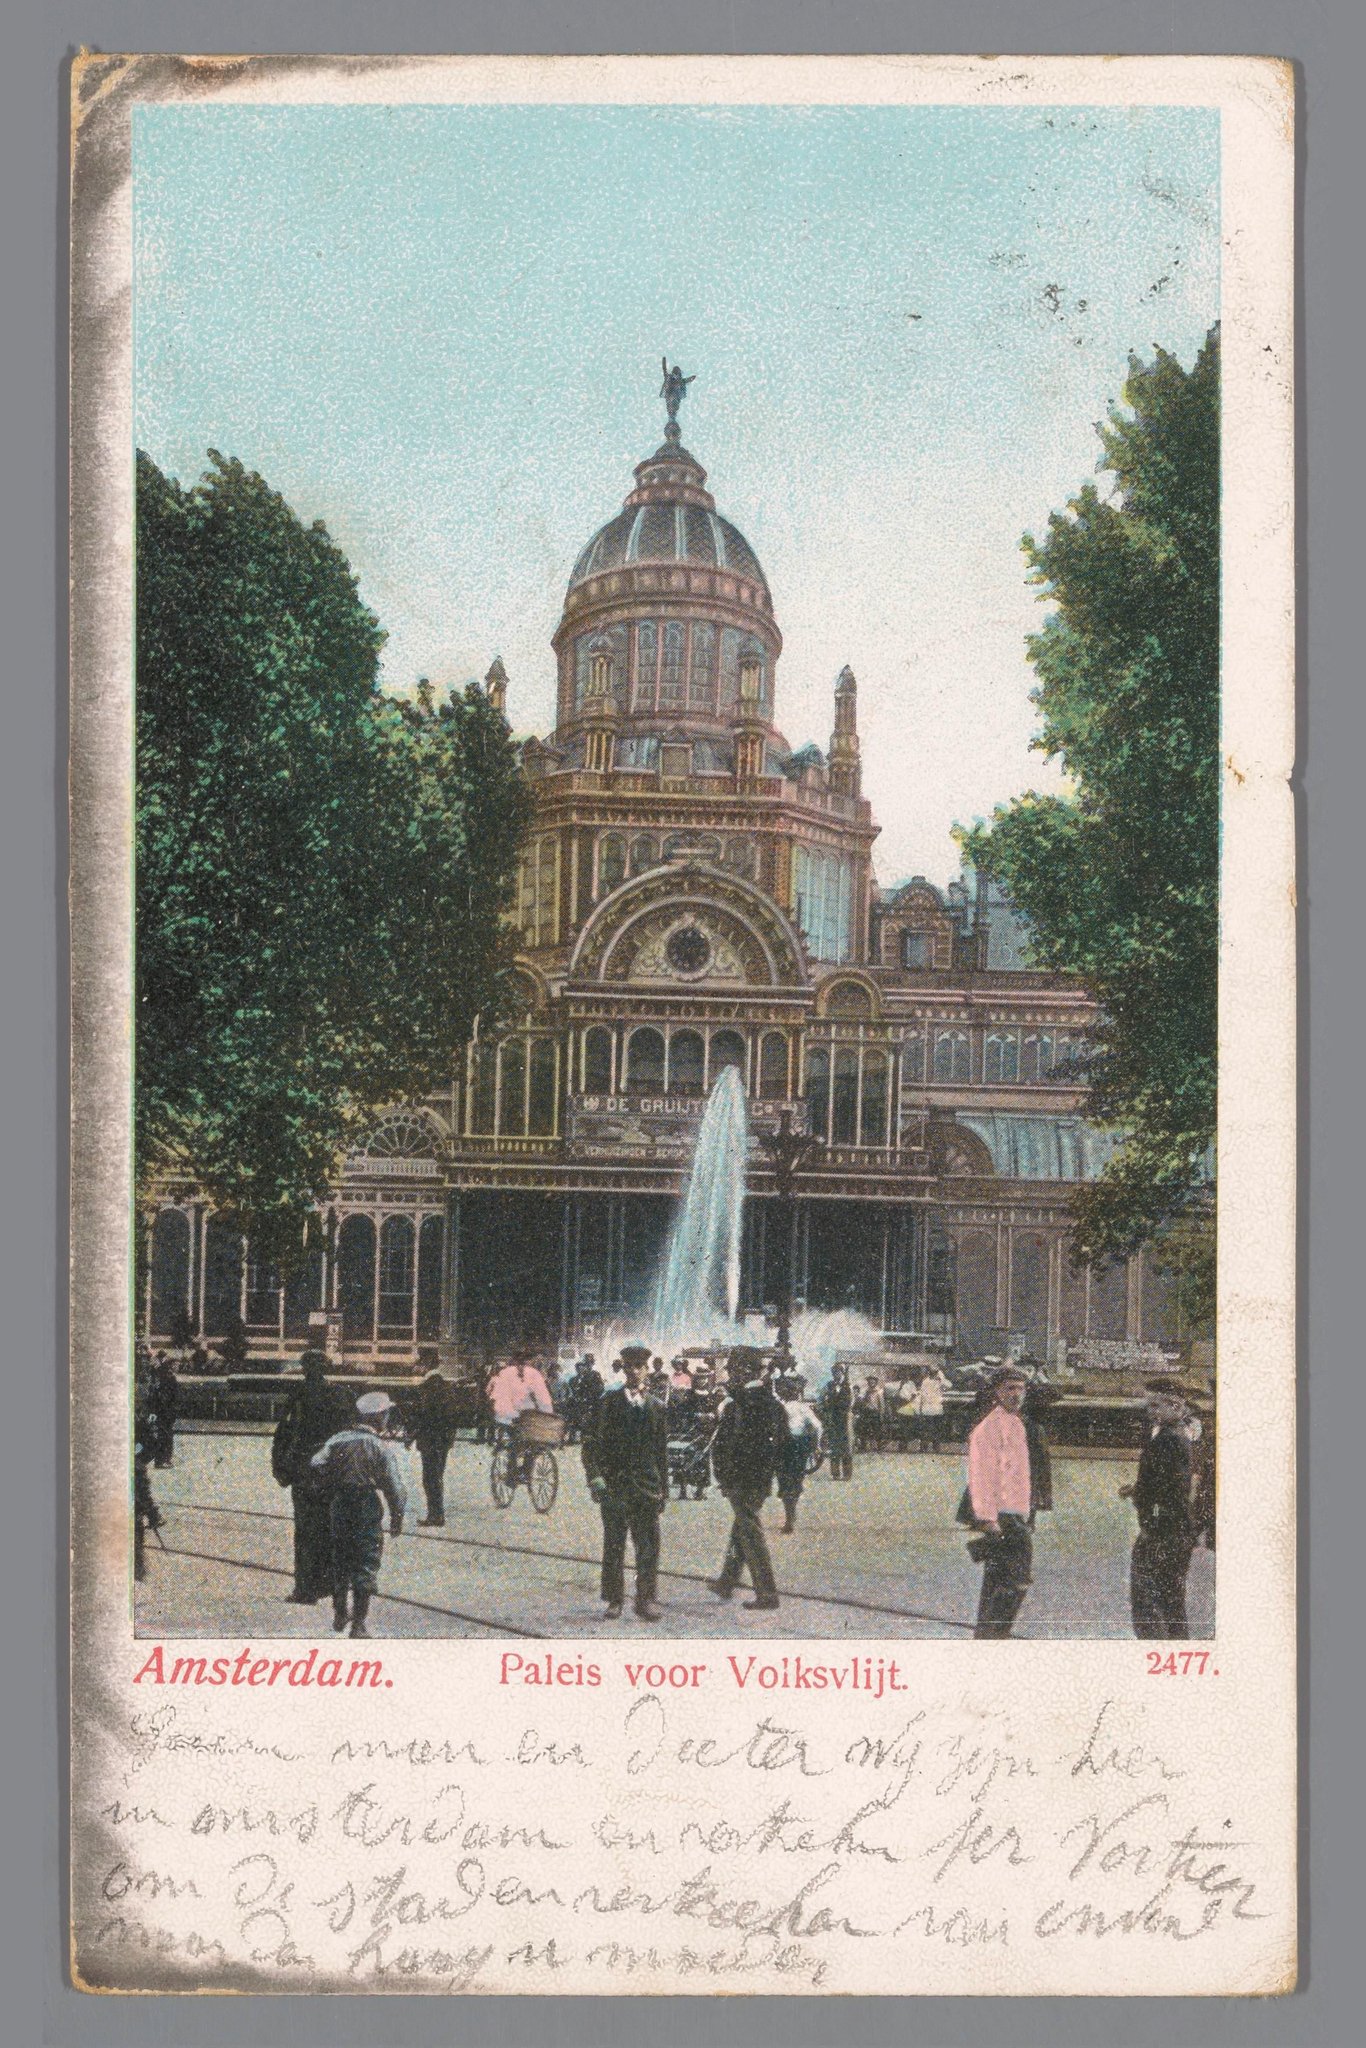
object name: ansichtkaart, prentbriefkaart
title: Amsterdam. Paleis voor Volksvlijt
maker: Anonymous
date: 1904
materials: cardboard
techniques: writing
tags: palace